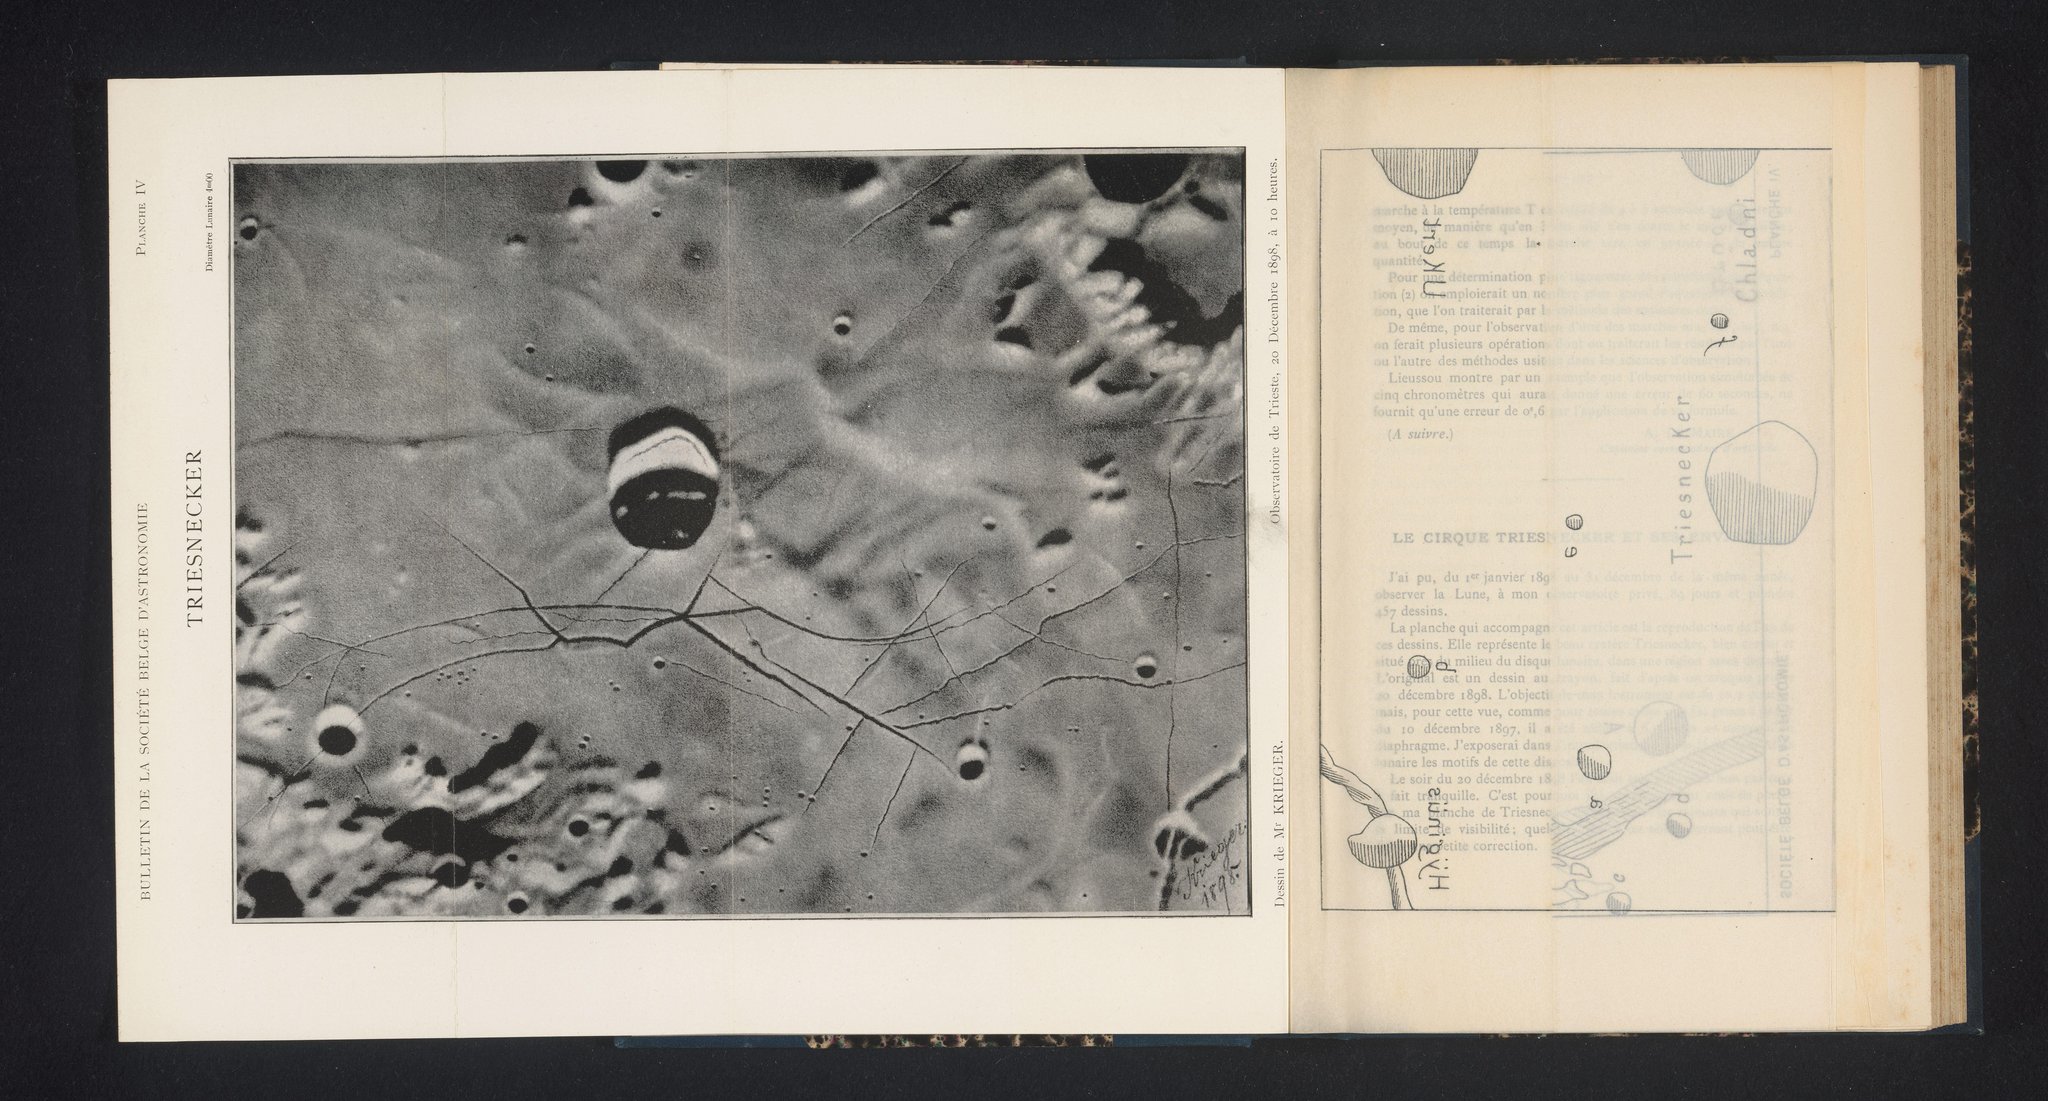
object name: photomechanical print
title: Kraters op de maan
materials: paper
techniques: autotype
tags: surface of the moon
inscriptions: inscription: ‘Dessin de Mr. Krieger Observatoire de Trieste, 20 Decembre 1898, a 10 heures.’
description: Transparante pagina voor prent als kaart met daarop de namen van de verschillende kraters.